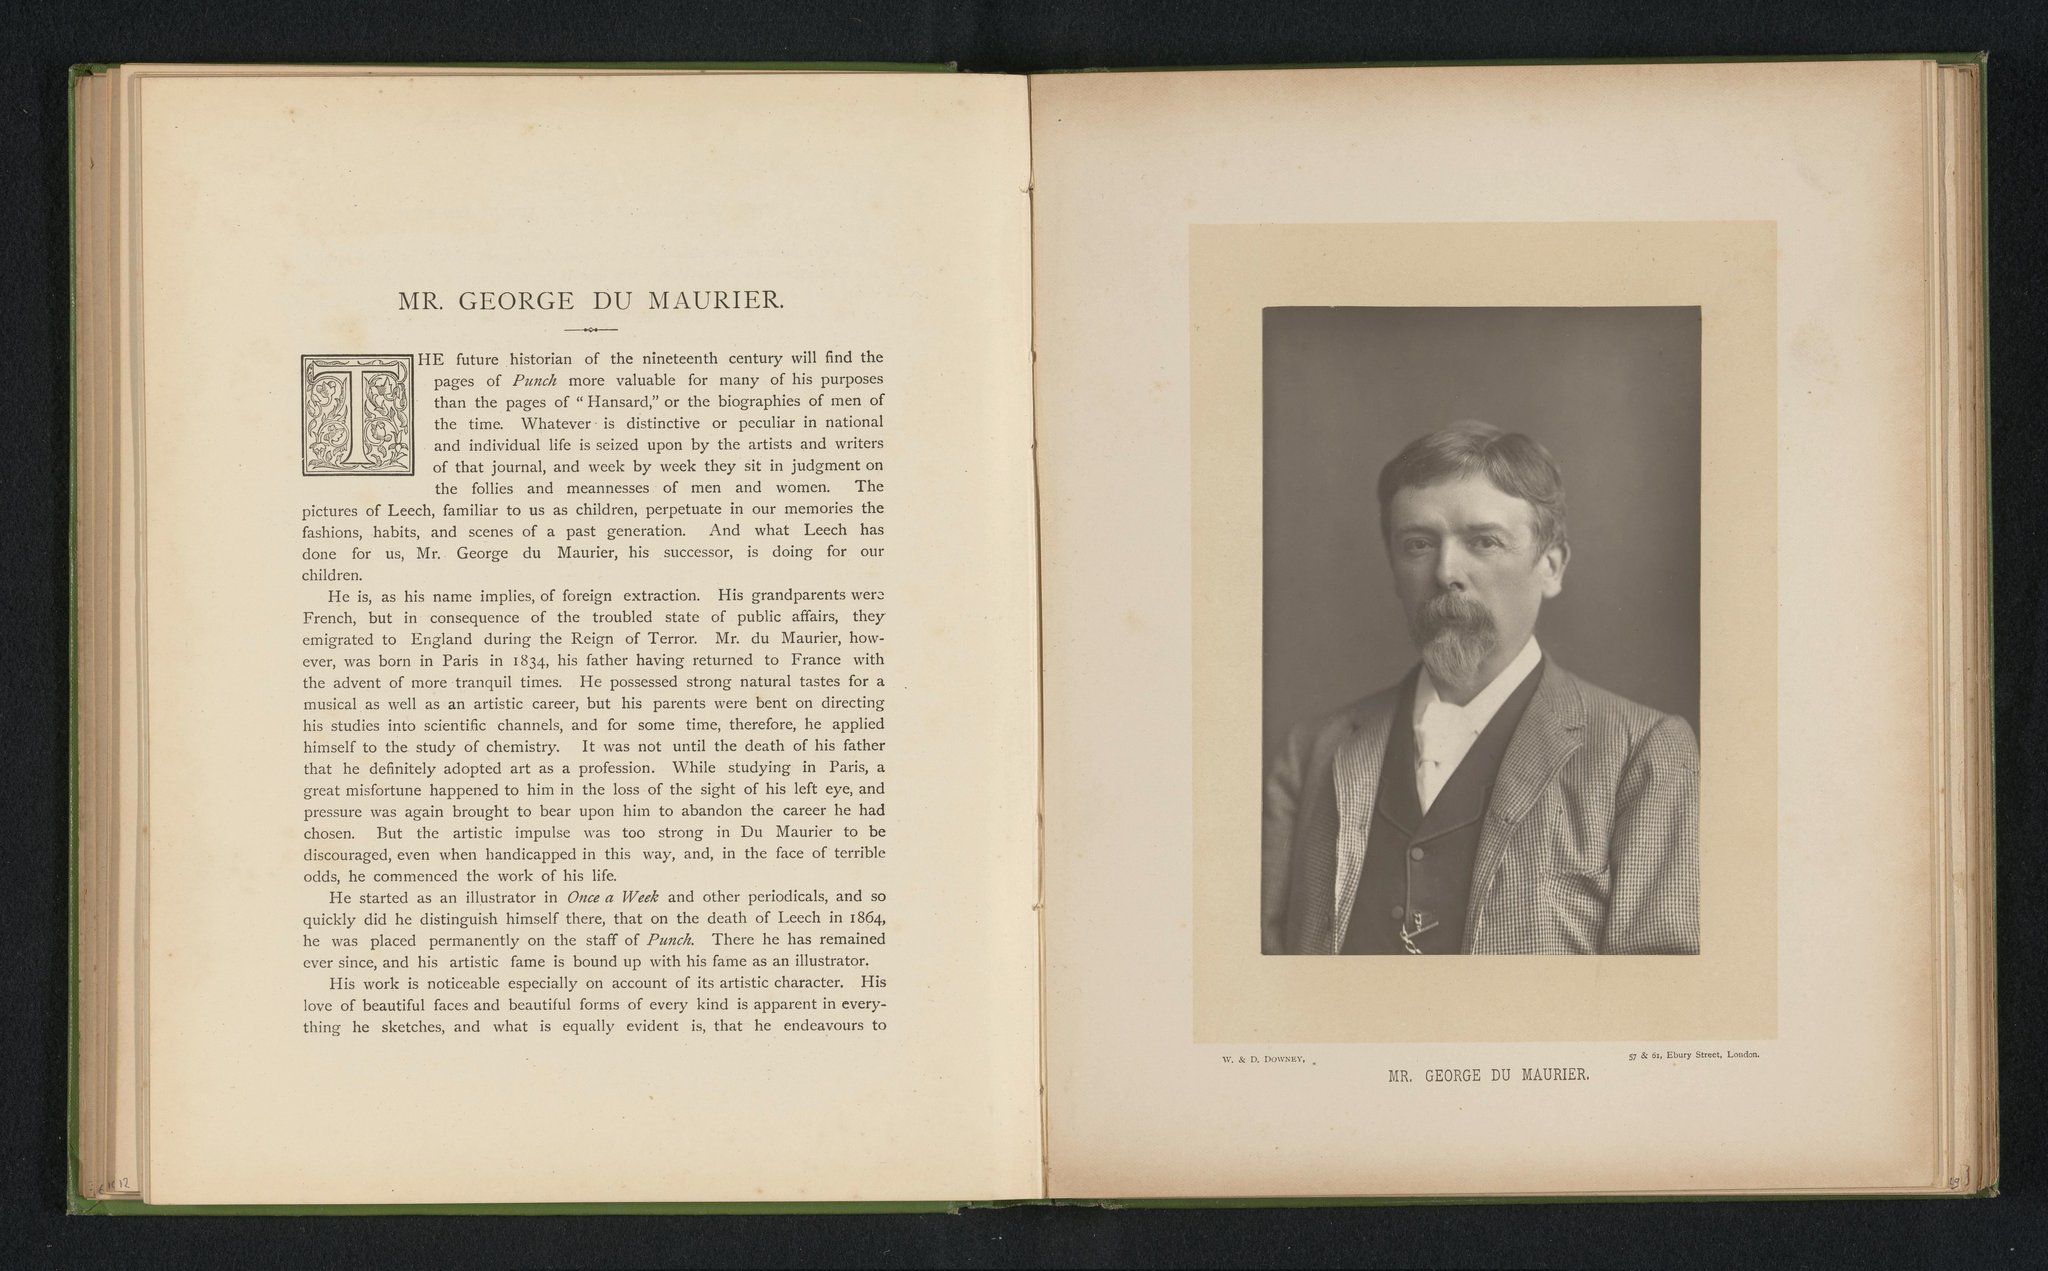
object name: photomechanical print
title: Mr. George du Maurier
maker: Anonymous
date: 1884-1894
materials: paper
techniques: woodburytype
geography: london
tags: draughtsman, george du maurier, portrait of a writer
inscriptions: inscription: ‘57 & 61, Elbury Street, London.’